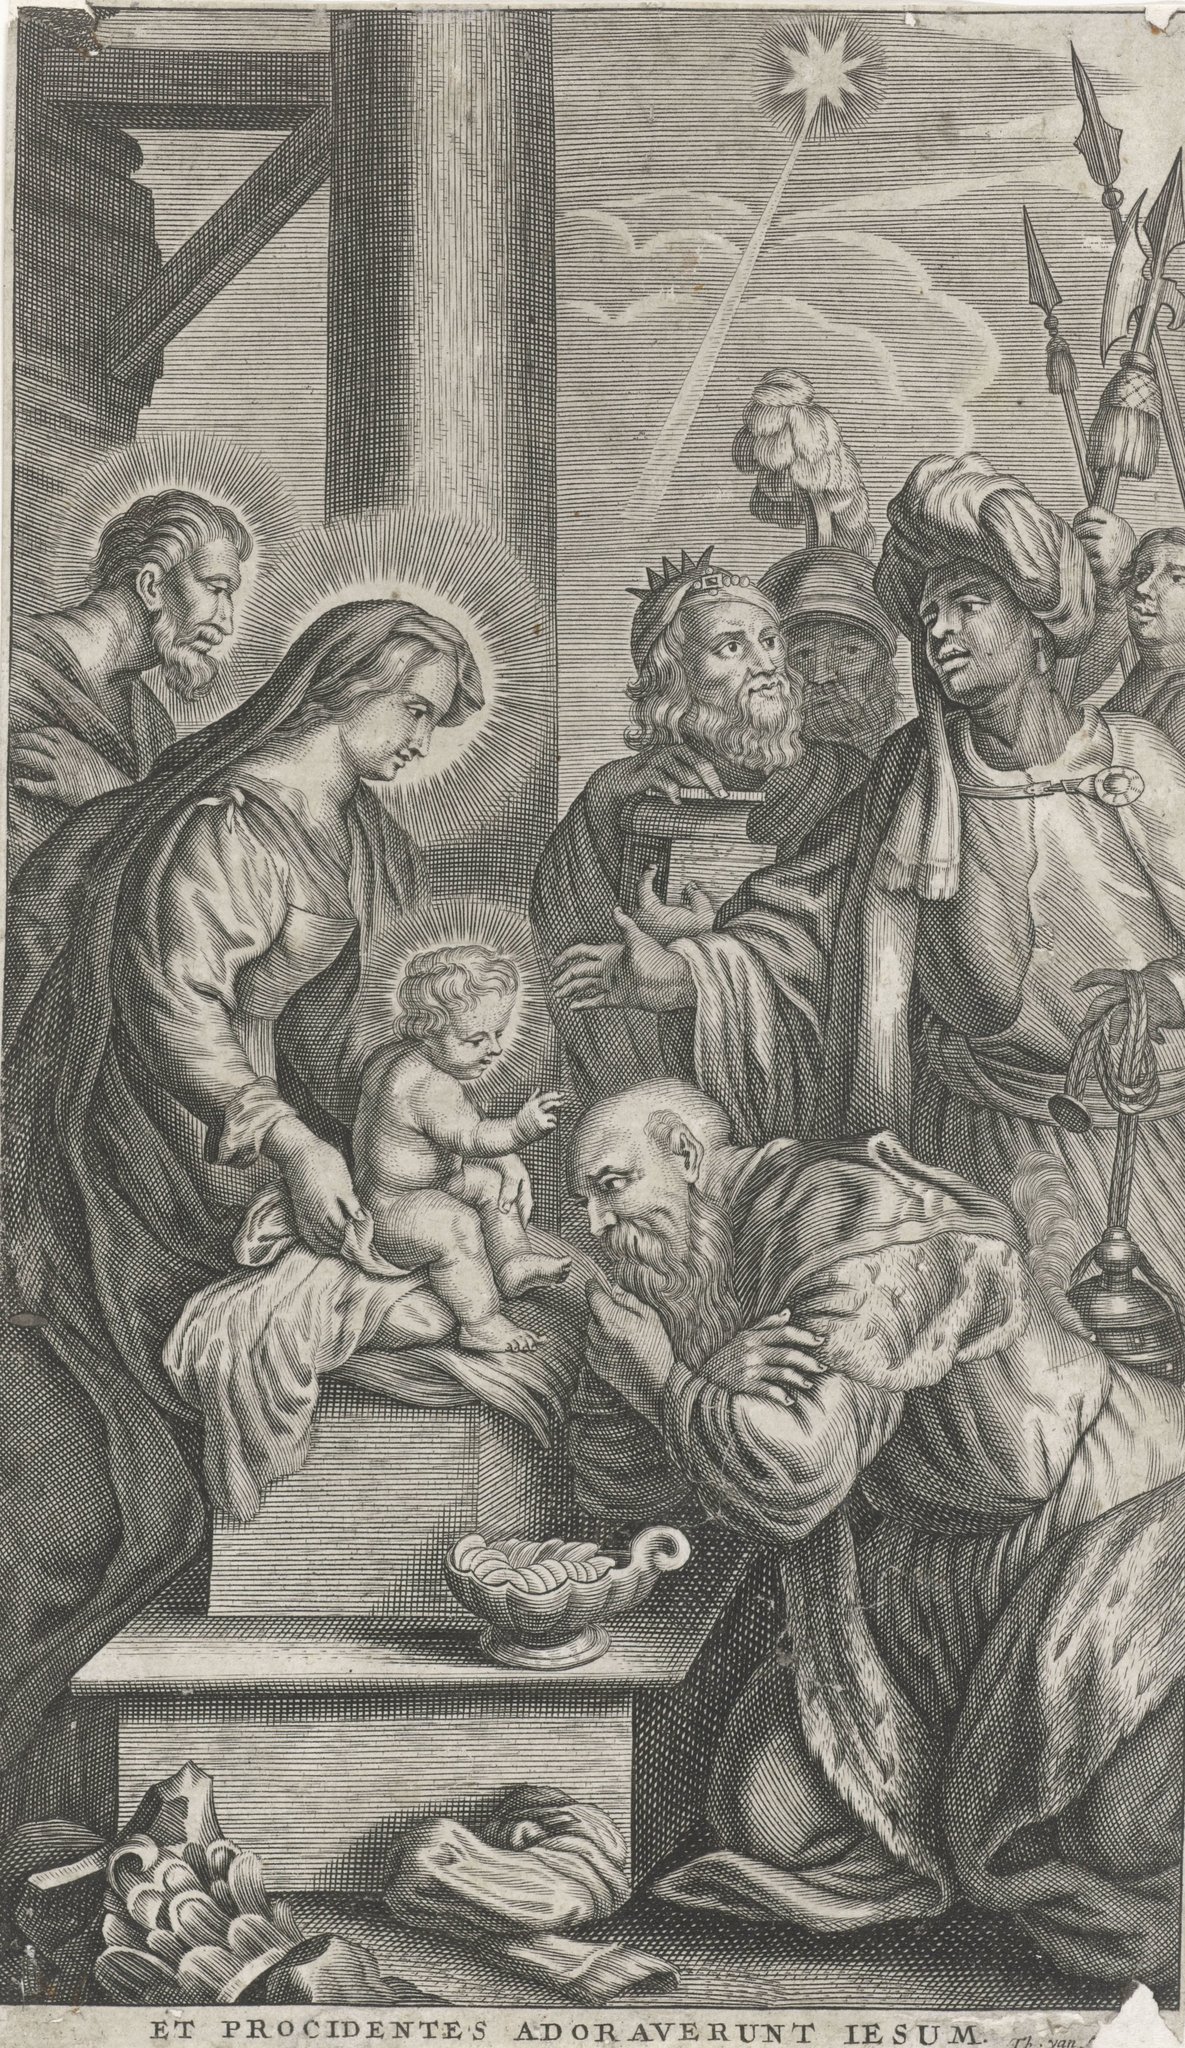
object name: print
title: Aanbidding der koningen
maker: theodor van merlen (ii)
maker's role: print maker, publisher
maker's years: 1609-1672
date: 1619-1672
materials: paper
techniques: engraving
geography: antwerp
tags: adoration of the kings: the wise men present their gifts to the christ-child (gold, frankincense and myrrh)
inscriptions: collector's mark: Lugt 2228